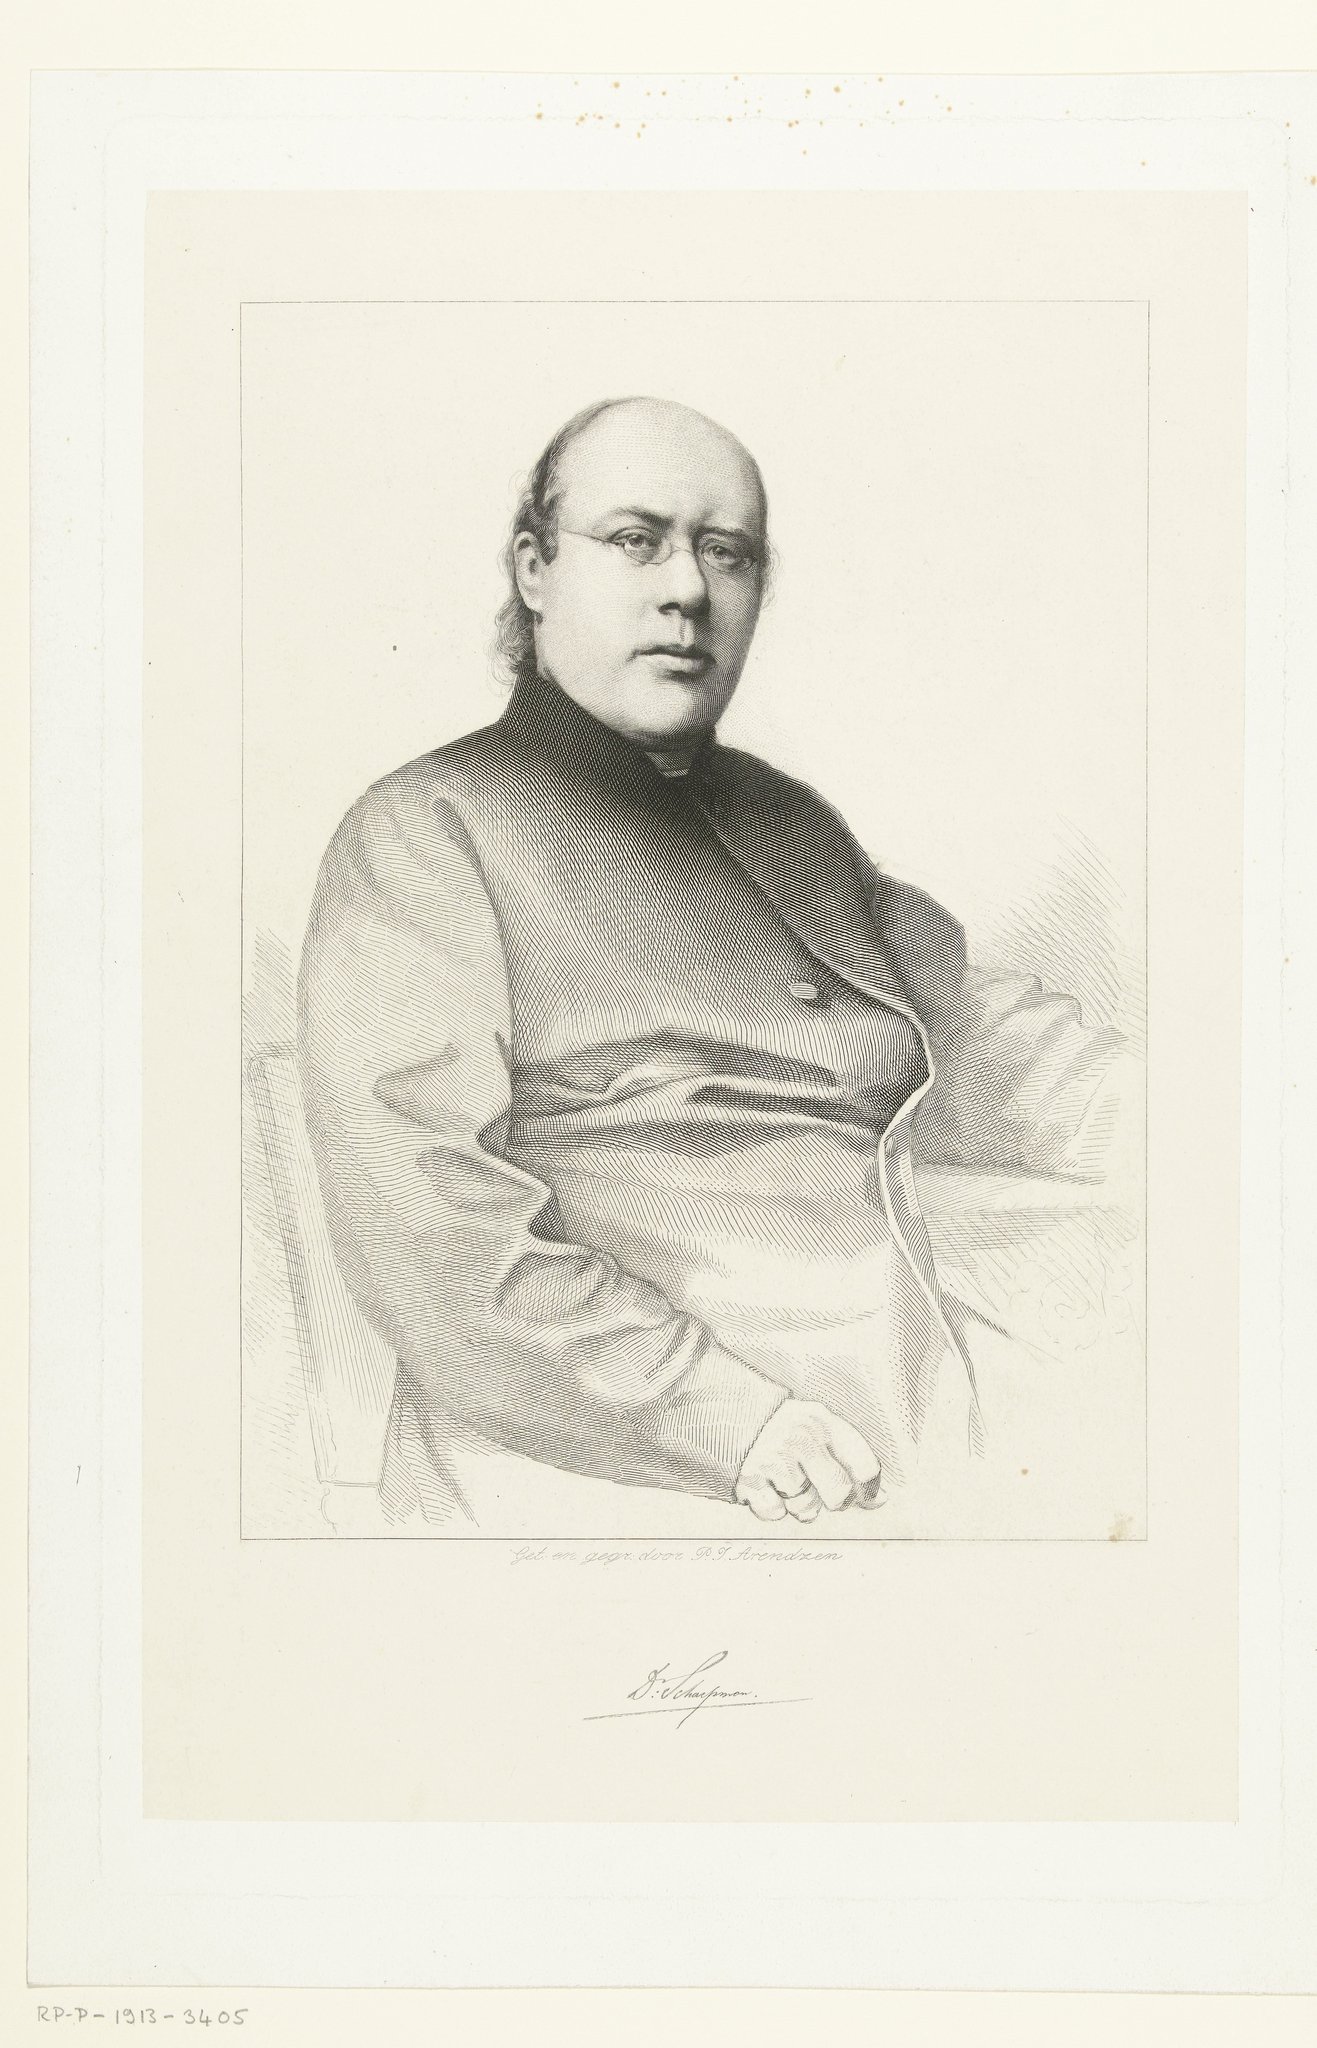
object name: print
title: Portret van Herman Johannes Aloysius Maria Schaepman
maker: petrus johannes arendzen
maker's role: draughtsman, print maker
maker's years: 1846-1932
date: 1880-1891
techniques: printmaking, engraving, etching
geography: netherlands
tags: rome, herman johannes aloysius maria schaepman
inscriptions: collector's mark: Lugt 2228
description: Portret van Herman Johannes Aloysius Maria Schaepman zittend. In de ondermarge zijn handtekening in facsimile.